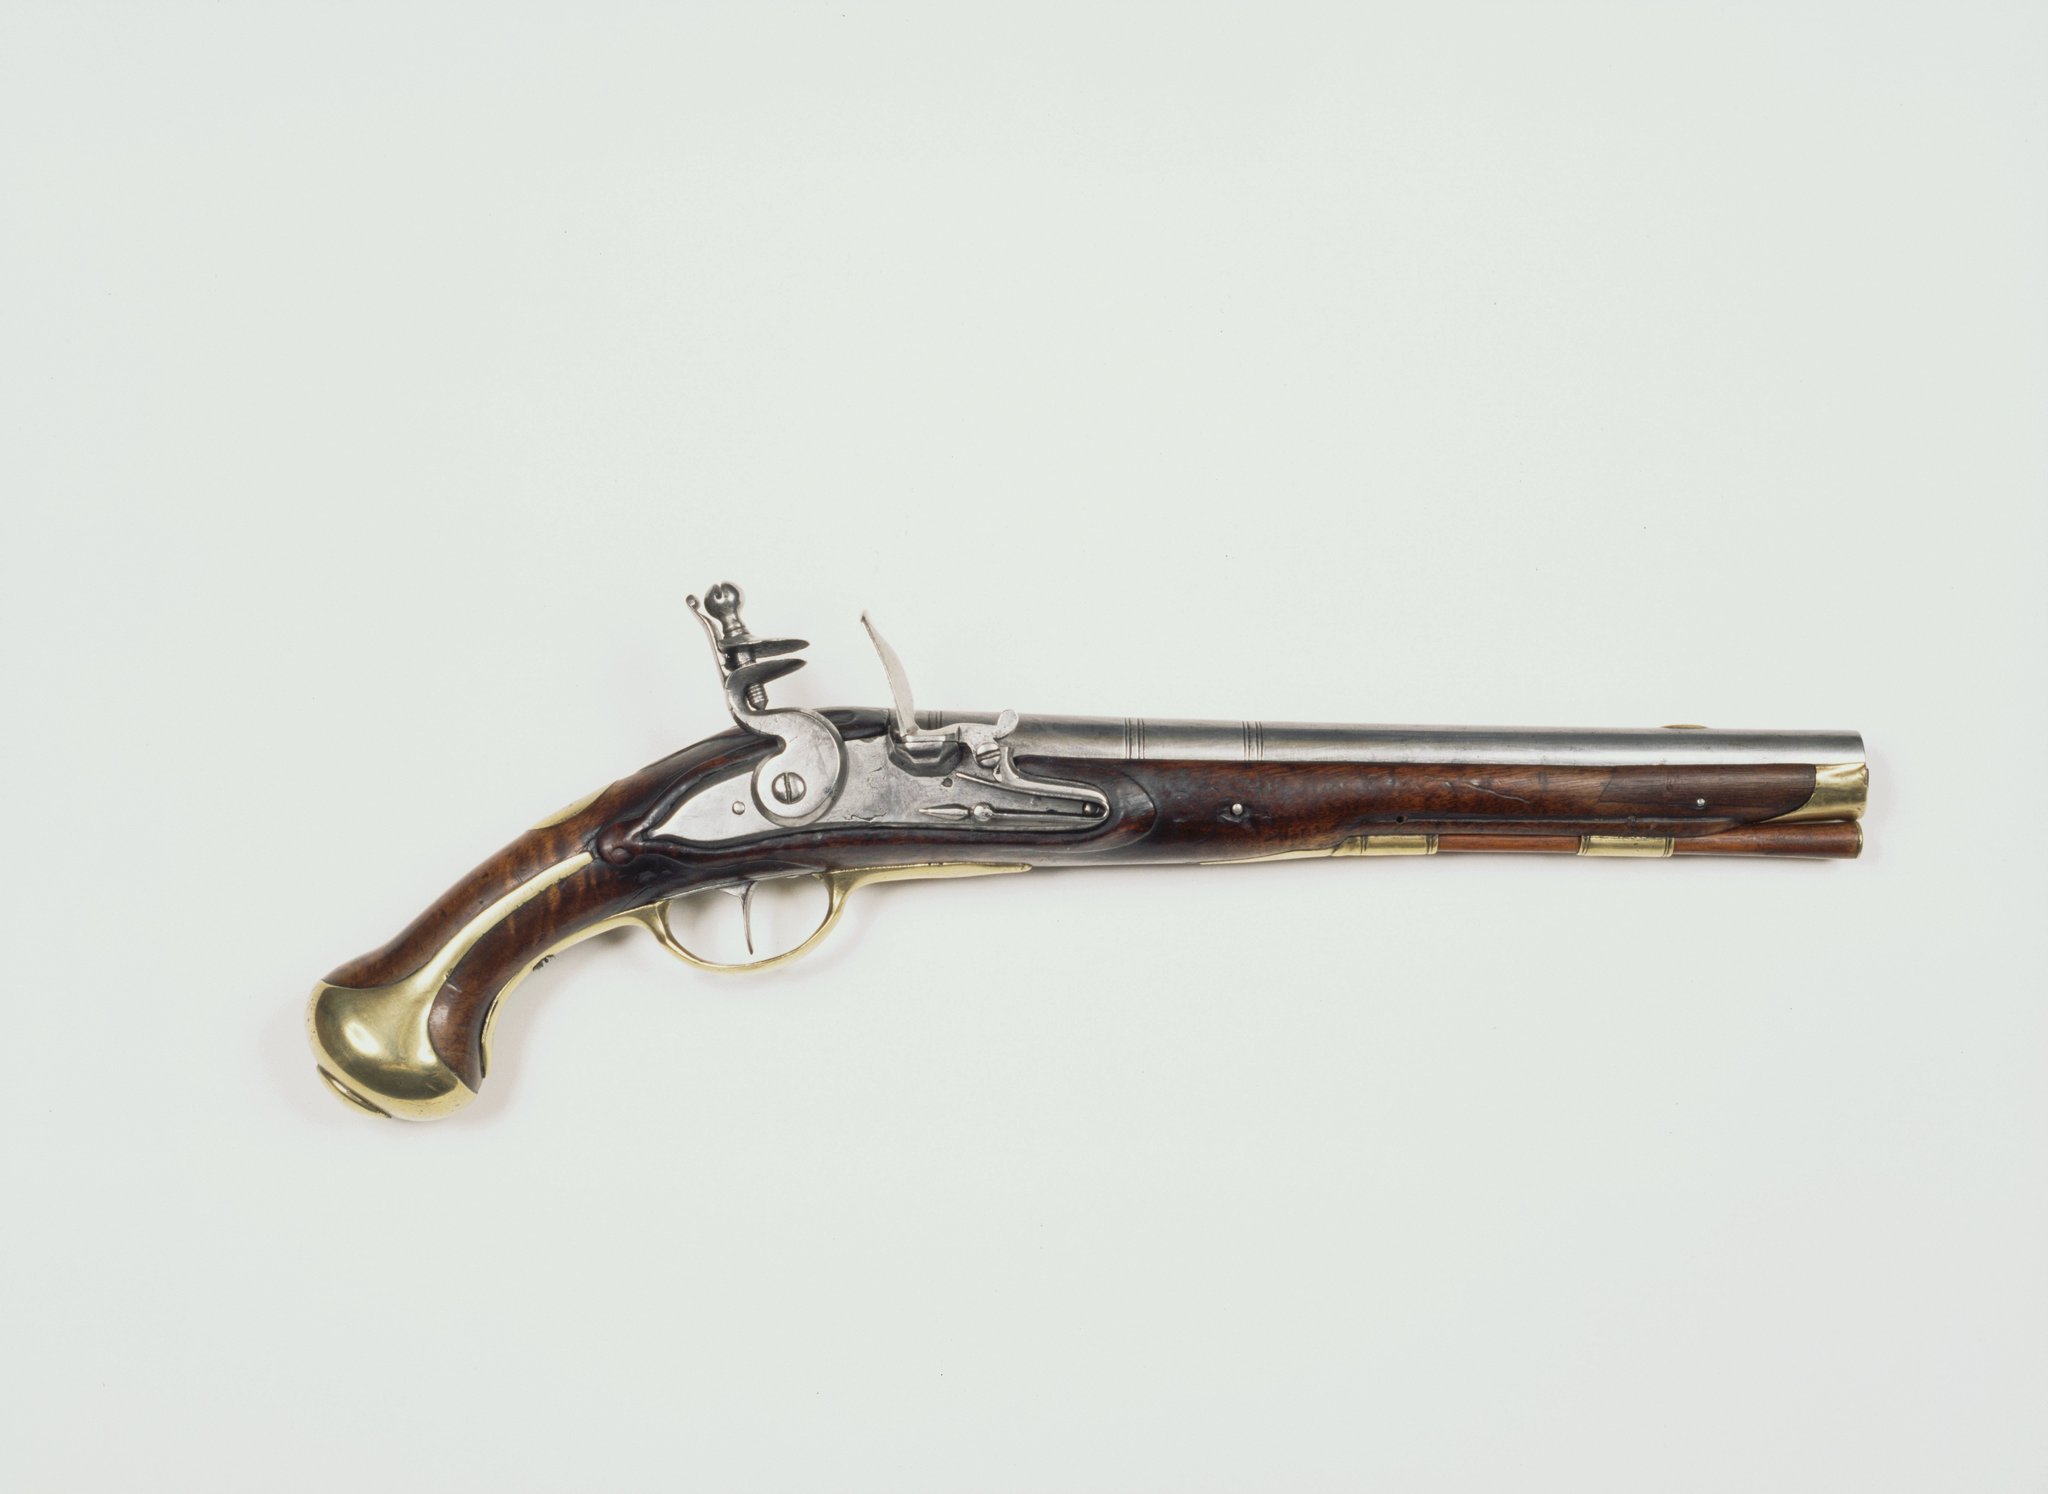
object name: flintlock pistol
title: Vuursteenpistool, Garde d'Honneurs, 1e Keizerrijk, 1813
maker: Anonymous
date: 1813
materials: brass, copper, iron, wood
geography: western europe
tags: netherlands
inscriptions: : ‘B.4’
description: Ruiterpistool, eind 18e eeuw, vuursteen. Ronde gladde loop met bandversiering, messing vizierkorrel. Op de loop een vijfpuntige ster. Zwanenhalshaan. IJzeren pan met vuurscherm. Messing zijplaat en messing beslag. Messing duimplaat waarop `B.4'. Weinig bewerkte lade, aan de voorzijde een halve messing band. Houten laadstok met messing plaatje. Het wapen heeft behoord aan de derde wachtmeester van de Tweede Compagnie der vier regimenten gardes d'honneur van Napoleon I.